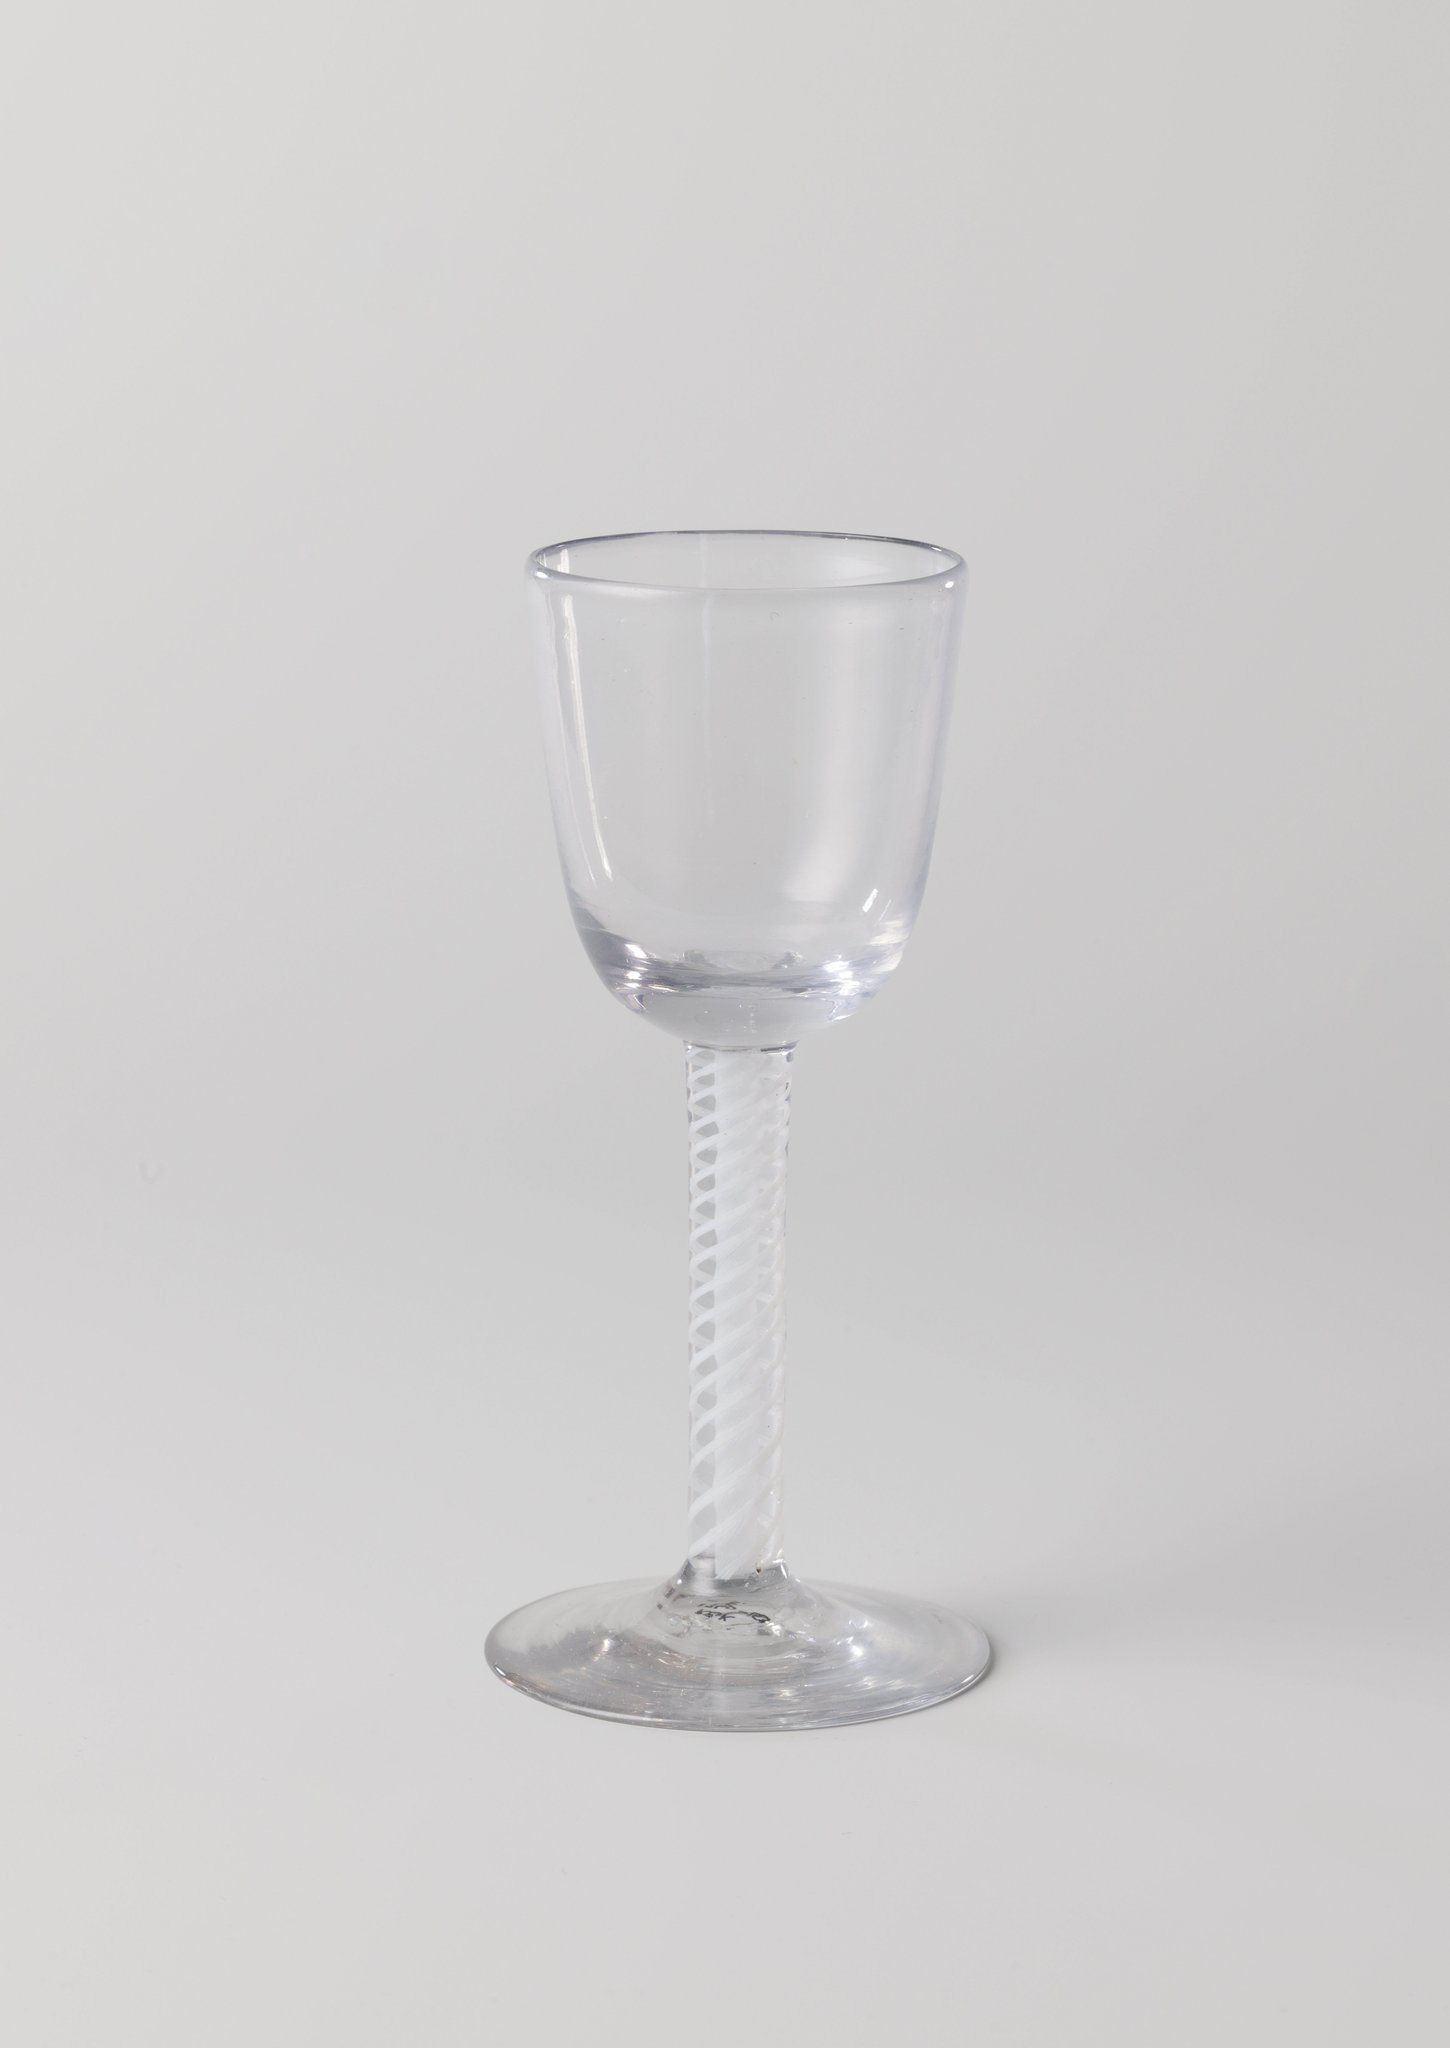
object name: slingerglas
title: Slingerglas met licht uitlopende kelk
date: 1750-1775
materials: glass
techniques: glassblowing, vetro a retorti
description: Slingerglas met conische voet en rechte stam. In de stam opaak witte spiralen rond witte netwerkspiraal. Conische kelk met afgeronde bodem.